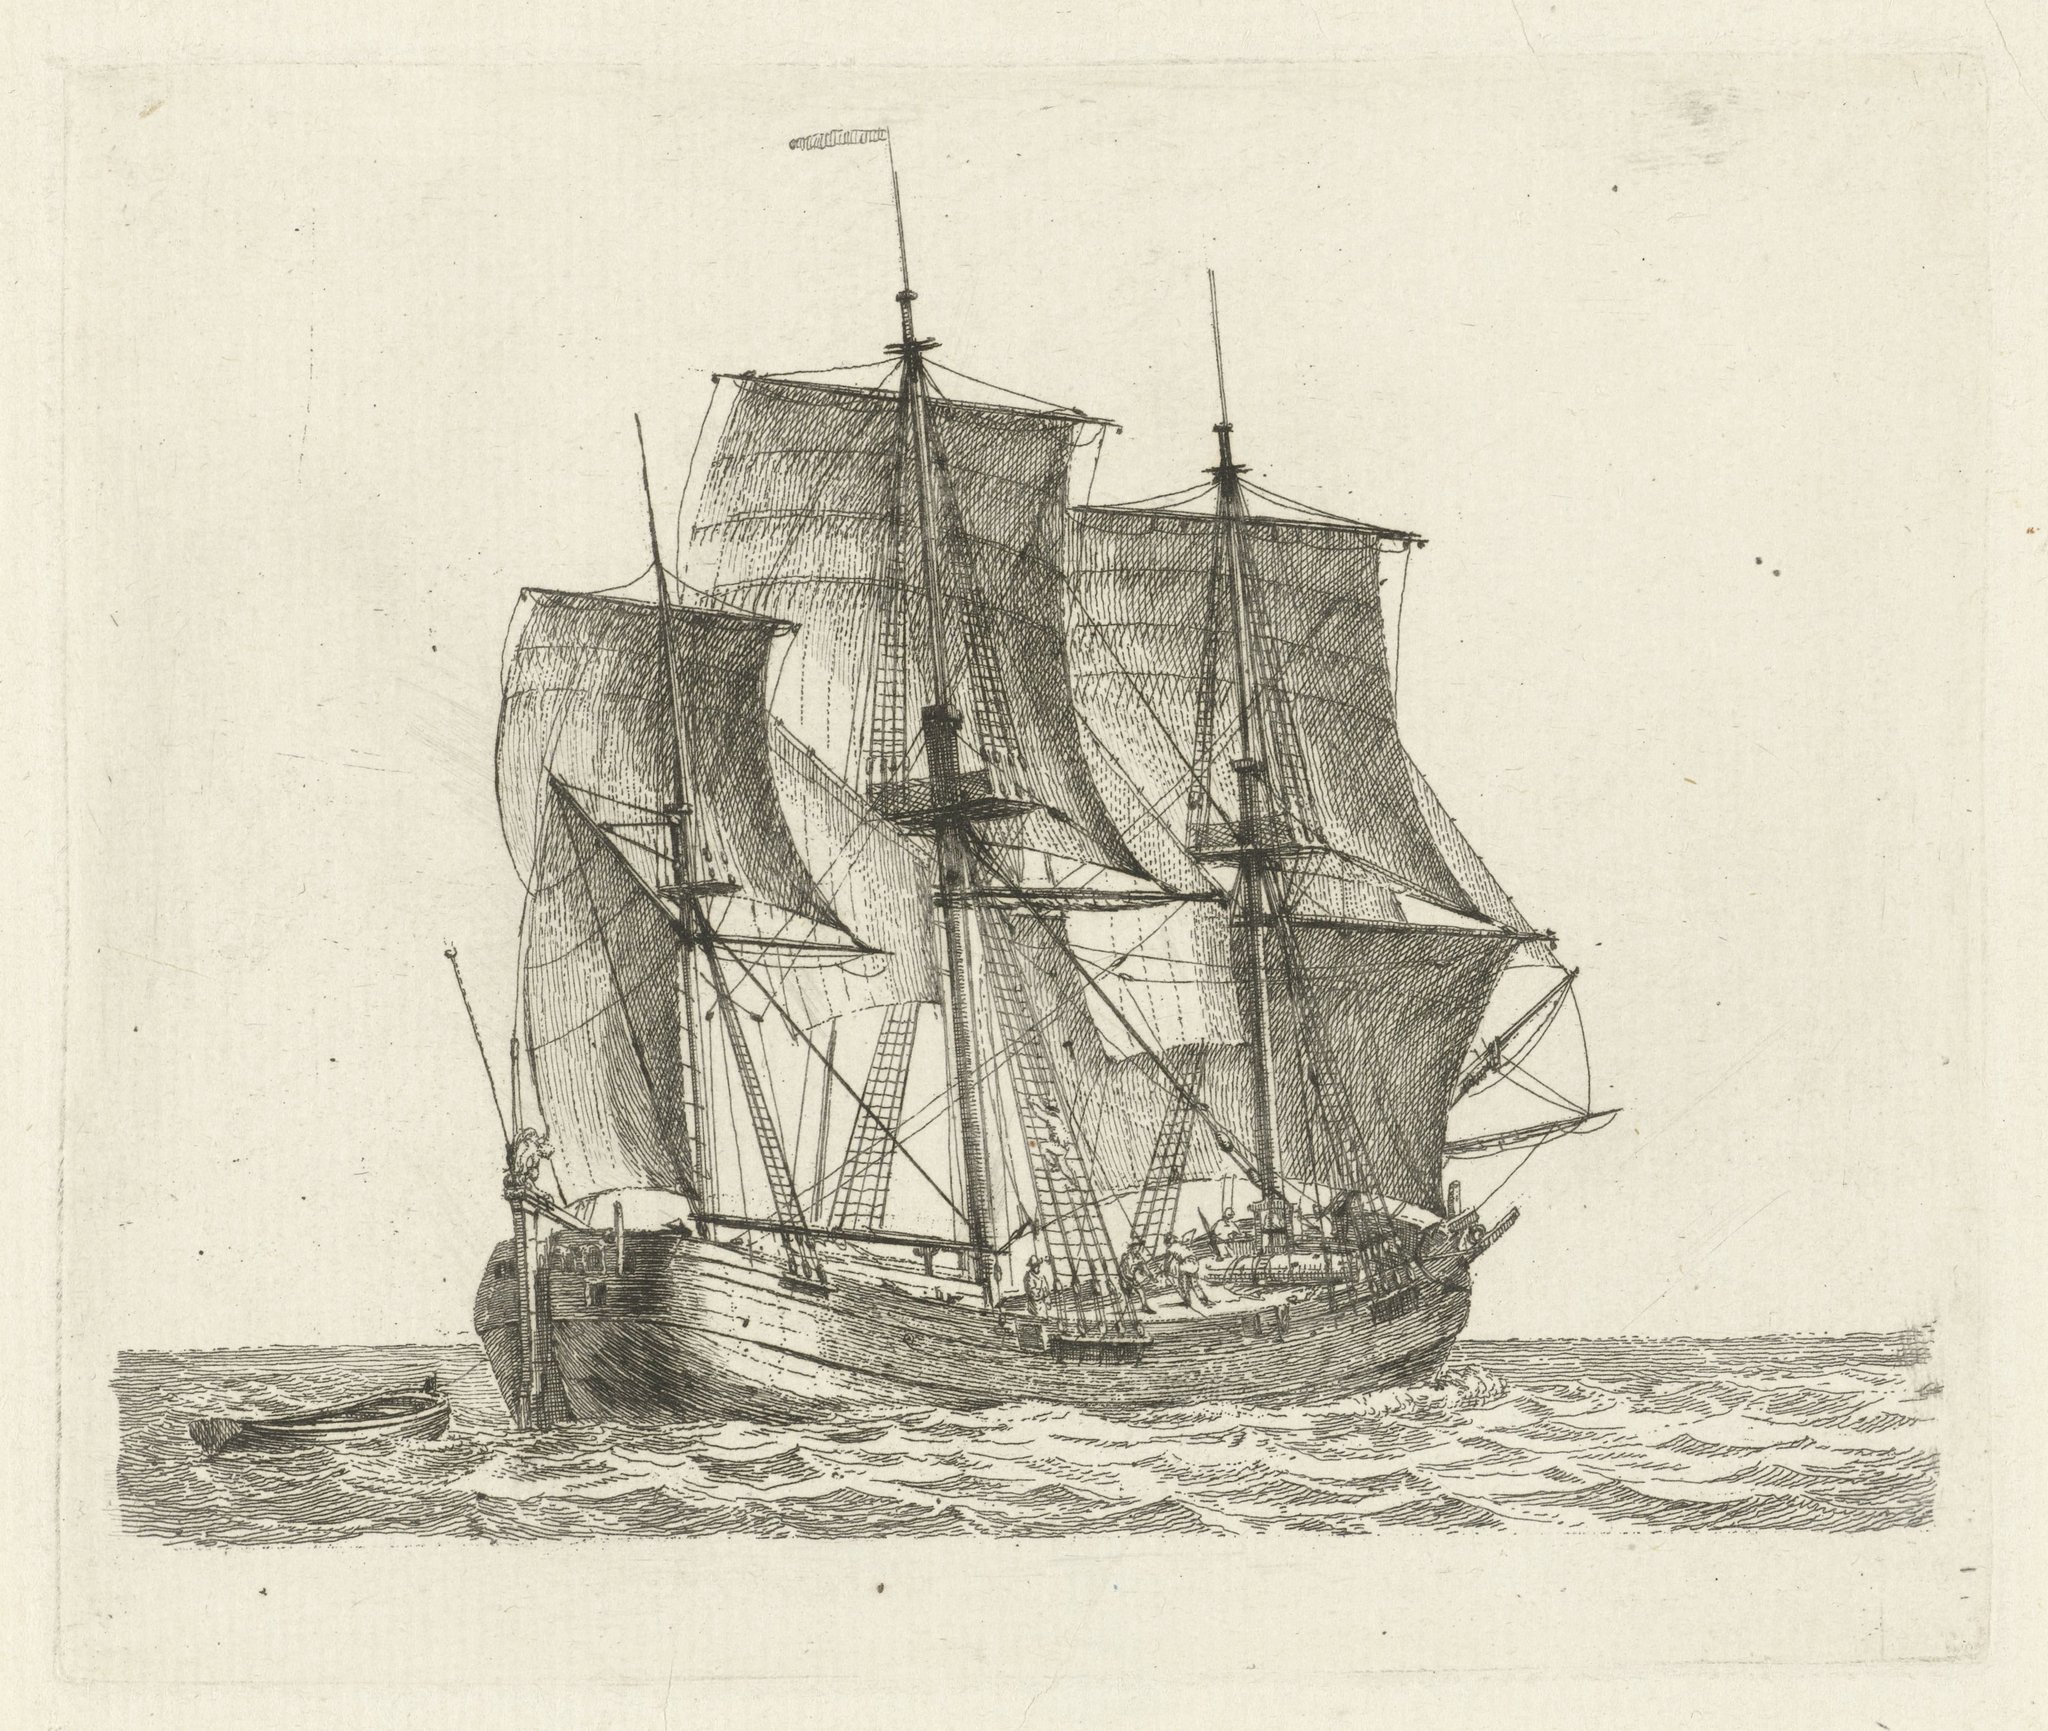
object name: print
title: Verschillende schepen serie C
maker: gerrit groenewegen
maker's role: draughtsman, print maker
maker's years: 1754-1826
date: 1789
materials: paper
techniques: etching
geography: rotterdam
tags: ships (in general)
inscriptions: collector's mark: Lugt 2228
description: Een driemaster met een sloep achter zich aantrekkend, schuin van achteren gezien. Op het schip zijn figuren te zien. Deze prent maakt deel uit van een serie van twaalf prenten met verschillende zeilschepen.